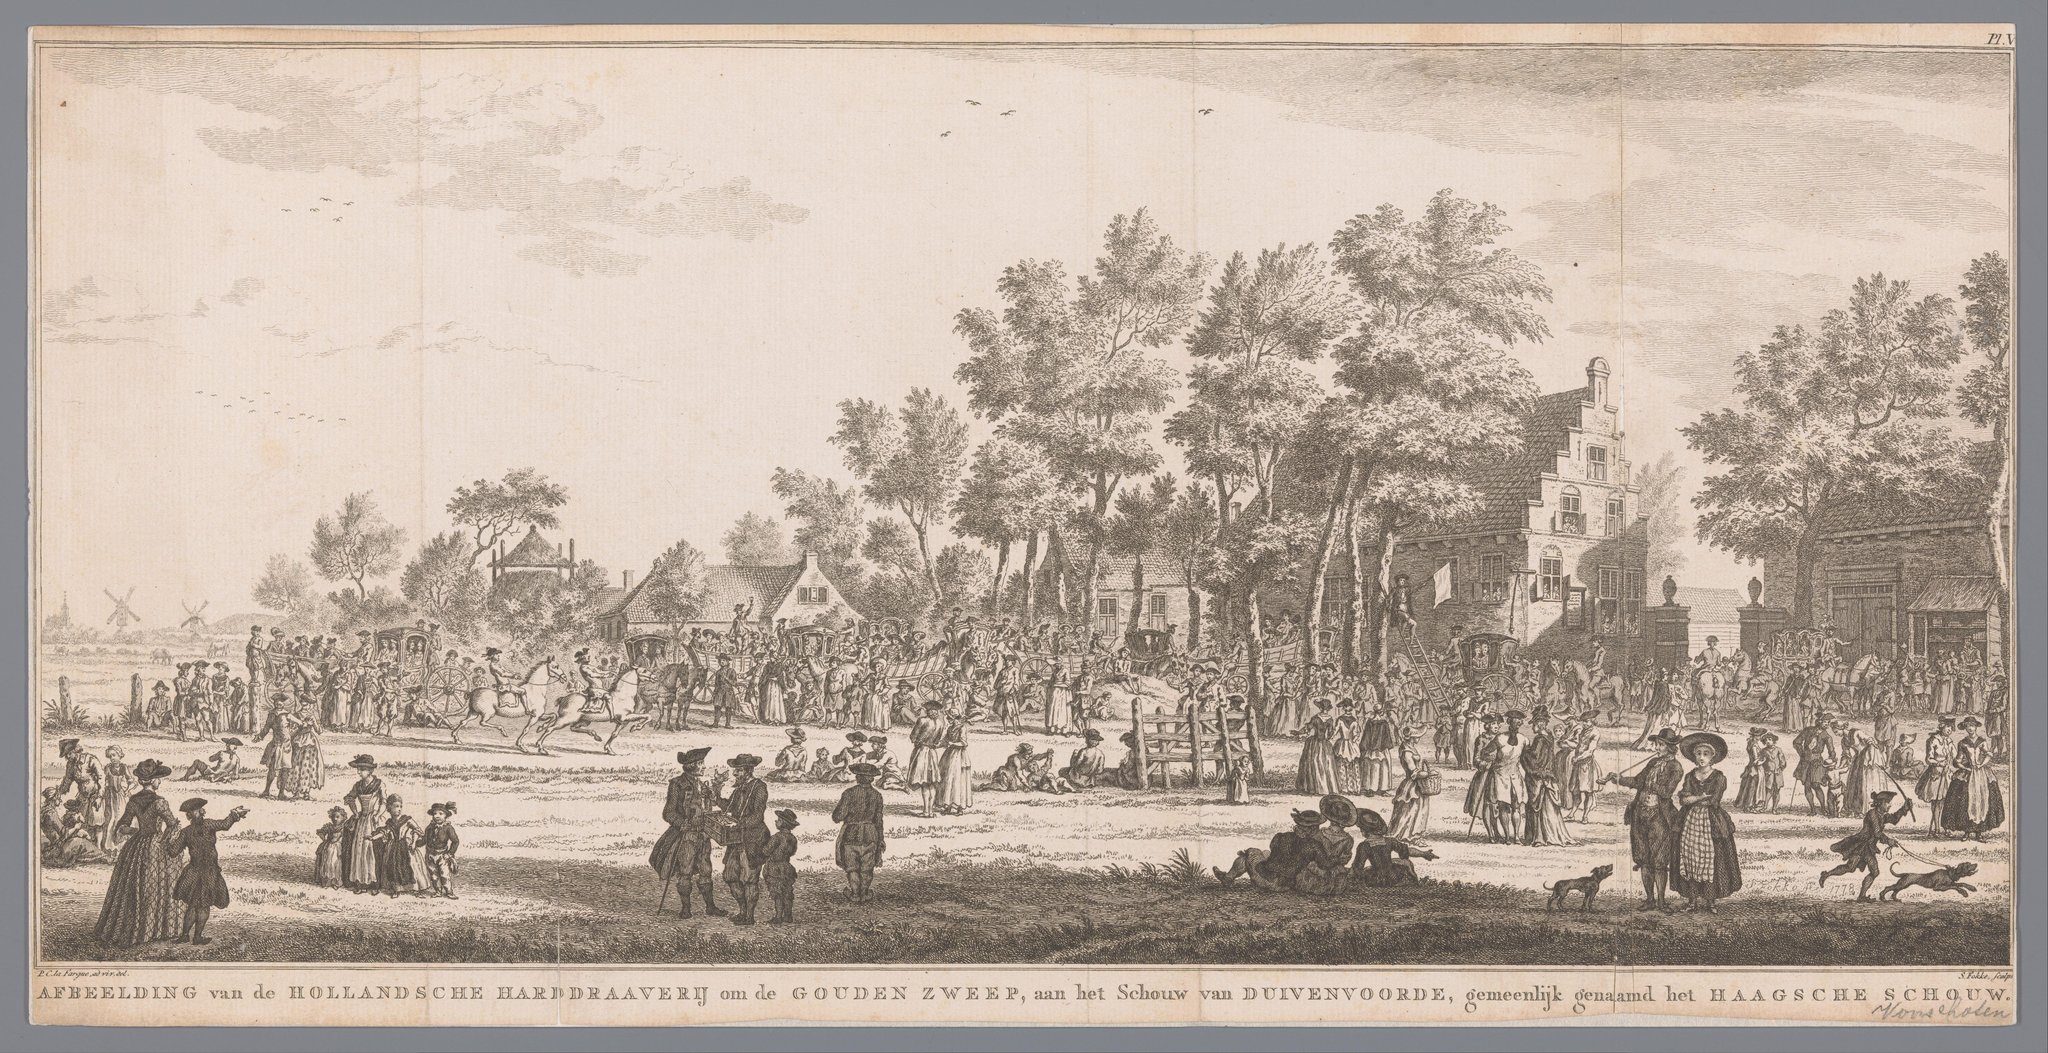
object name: print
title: Hollandse harddraverij, ca. 1775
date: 1778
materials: paper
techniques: etching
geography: amsterdam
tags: horse-racing, the hague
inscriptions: date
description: De Hollandse harddraverij om de gouden zweep aan het Haagsche Schouw, ca. 1775. Paardenraces op een vlakte buiten de stad Den Haag, met veel publiek zittend op de grond of in wagens en rijtuigen. Gemerkt rechtsboven: Pl. V.